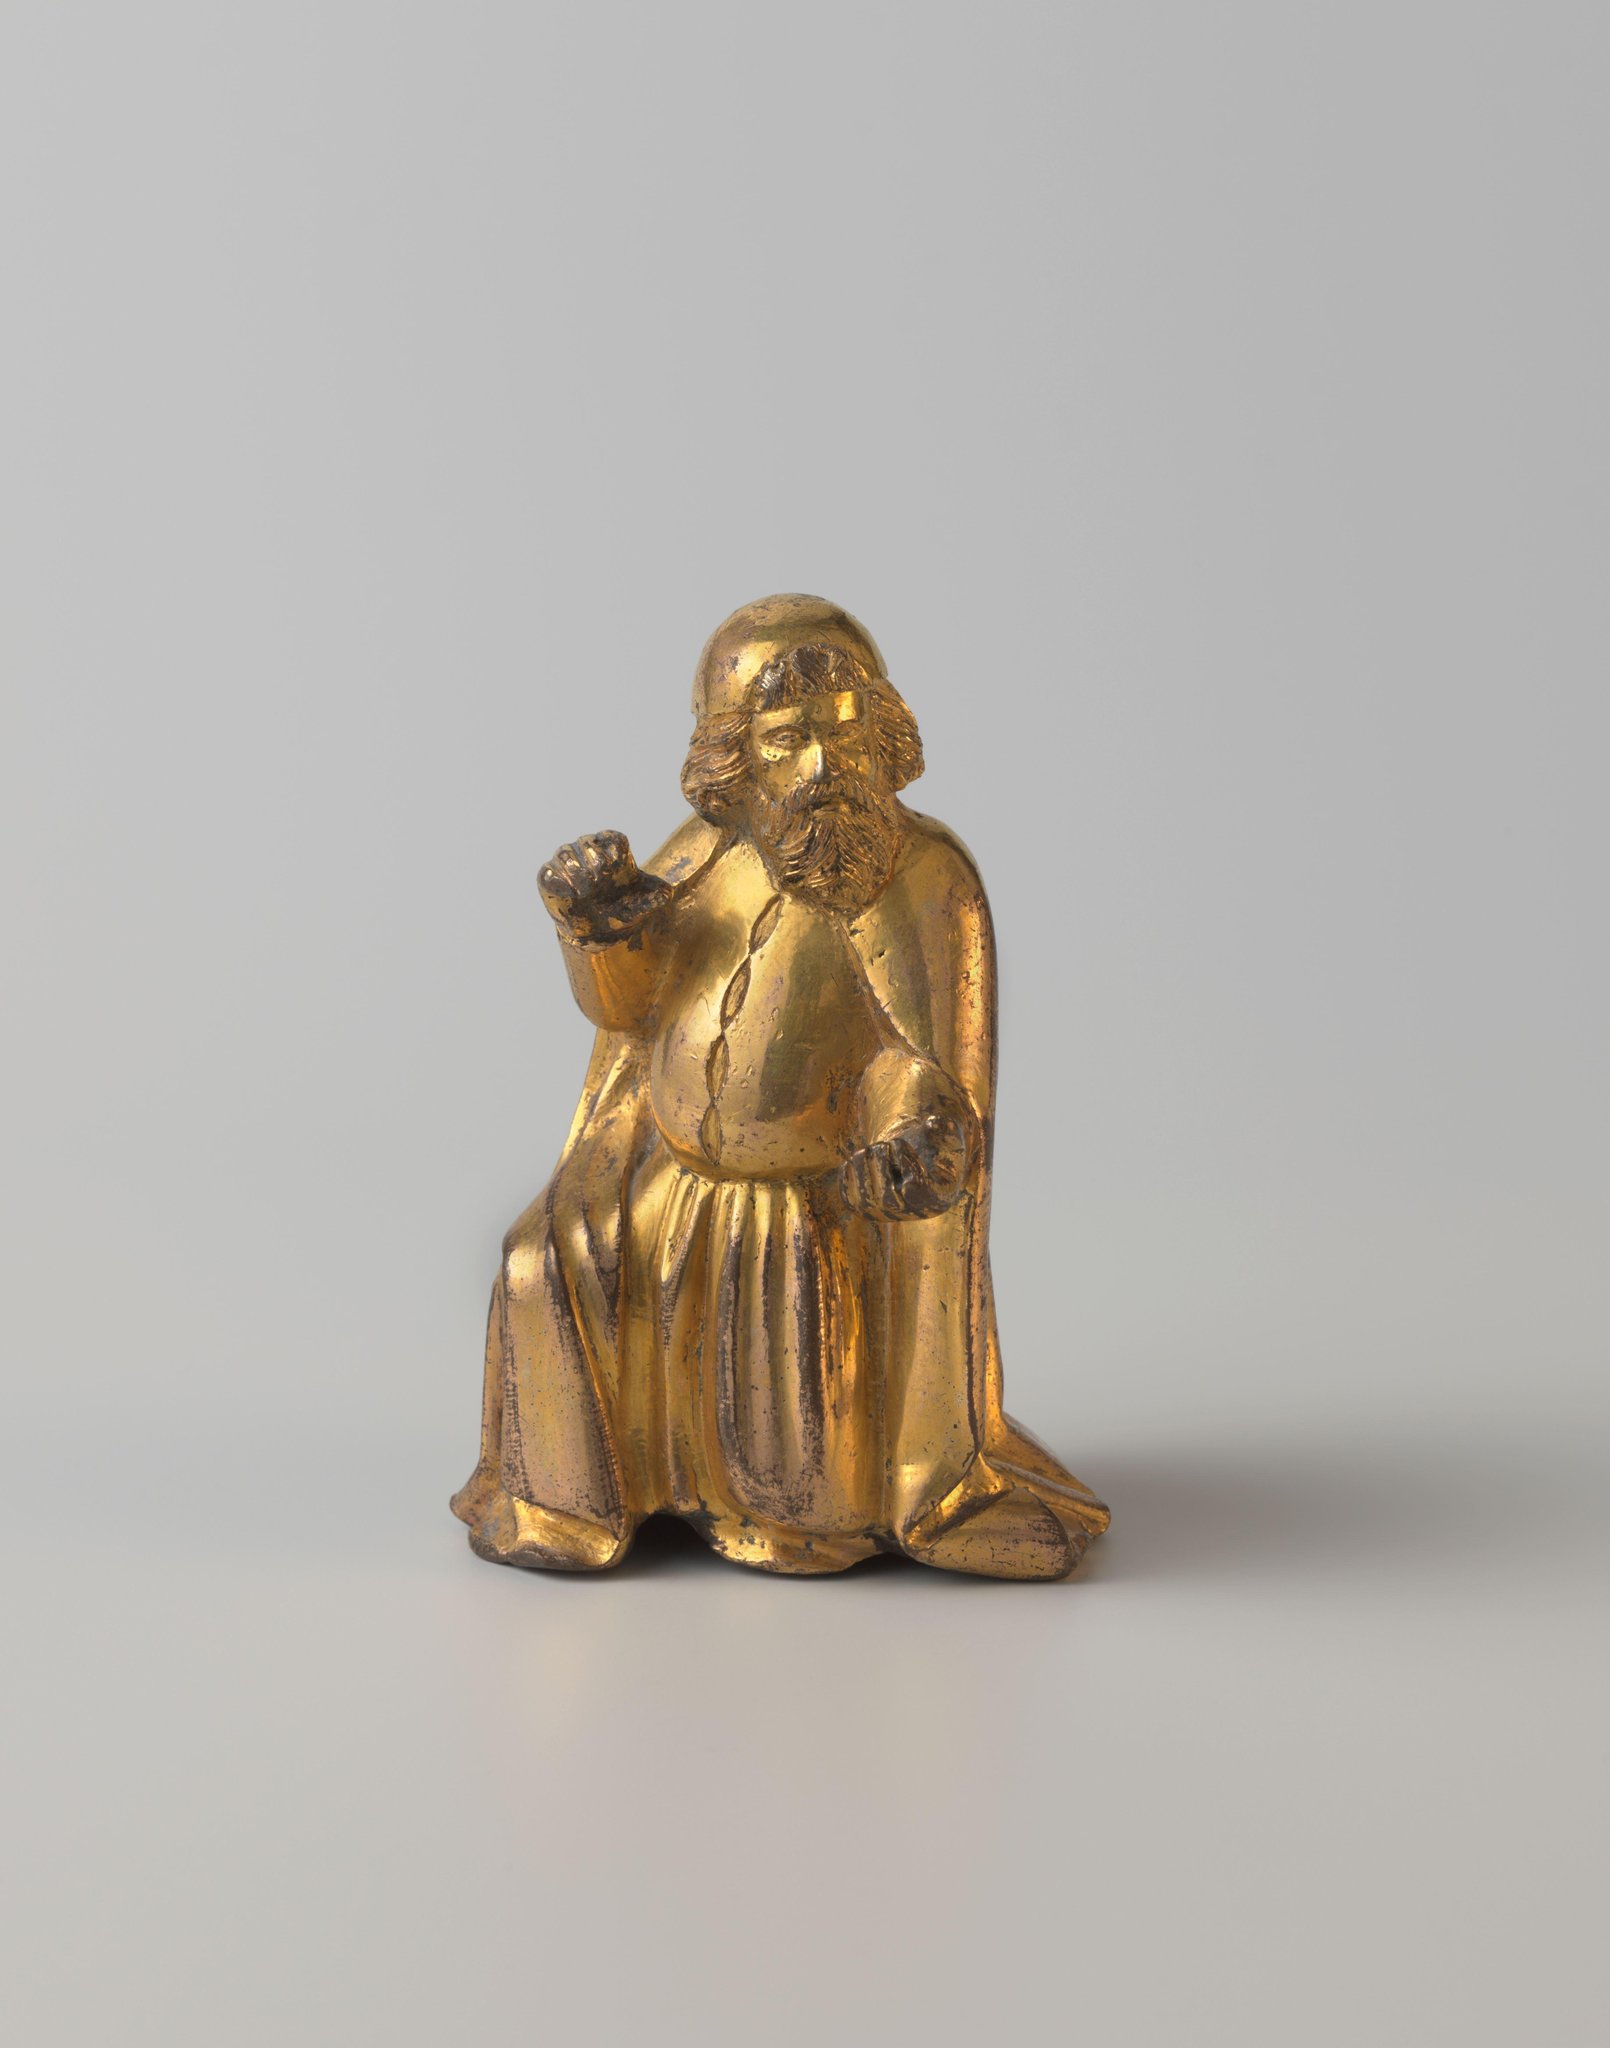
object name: figure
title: Two kneeling prophets (from a reliquary châsse)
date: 1400-1410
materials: bronze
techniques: casting, metalworking, gilding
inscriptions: inscription, on the bottom, in white paint: ‘28’, inscription, on the bottom, in red paint: ‘PM 531’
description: Two kneeling male figures. Gilt bronze. Southern Netherlands (?), 1400 - 1425.